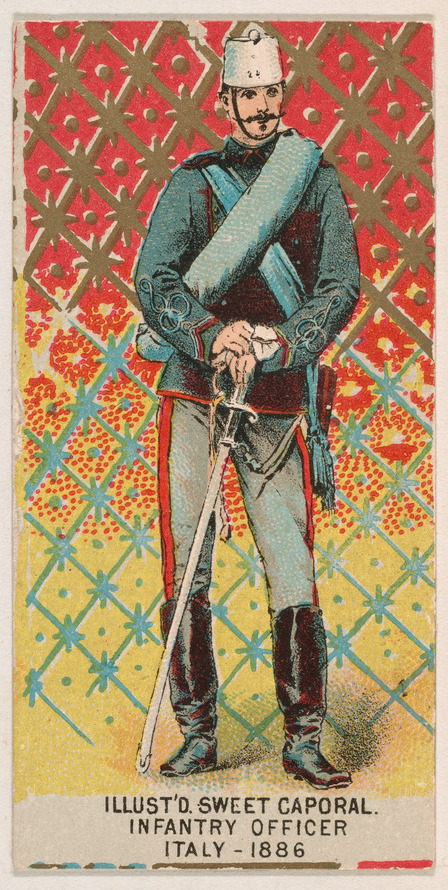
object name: print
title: Infantry Officer, Italy, 1886, from the Military Series (N224) issued by Kinney Tobacco Company to promote Sweet Caporal Cigarettes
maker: kinney brothers tobacco company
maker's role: publisher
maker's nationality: american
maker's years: 1869-2011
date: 1888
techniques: color lithograph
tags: military,swords,men